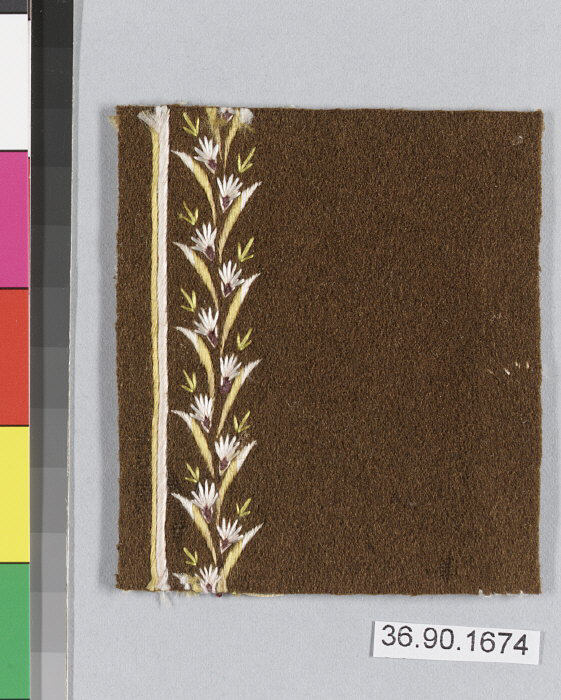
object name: sample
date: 1801-1833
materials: felt, silk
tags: flowers